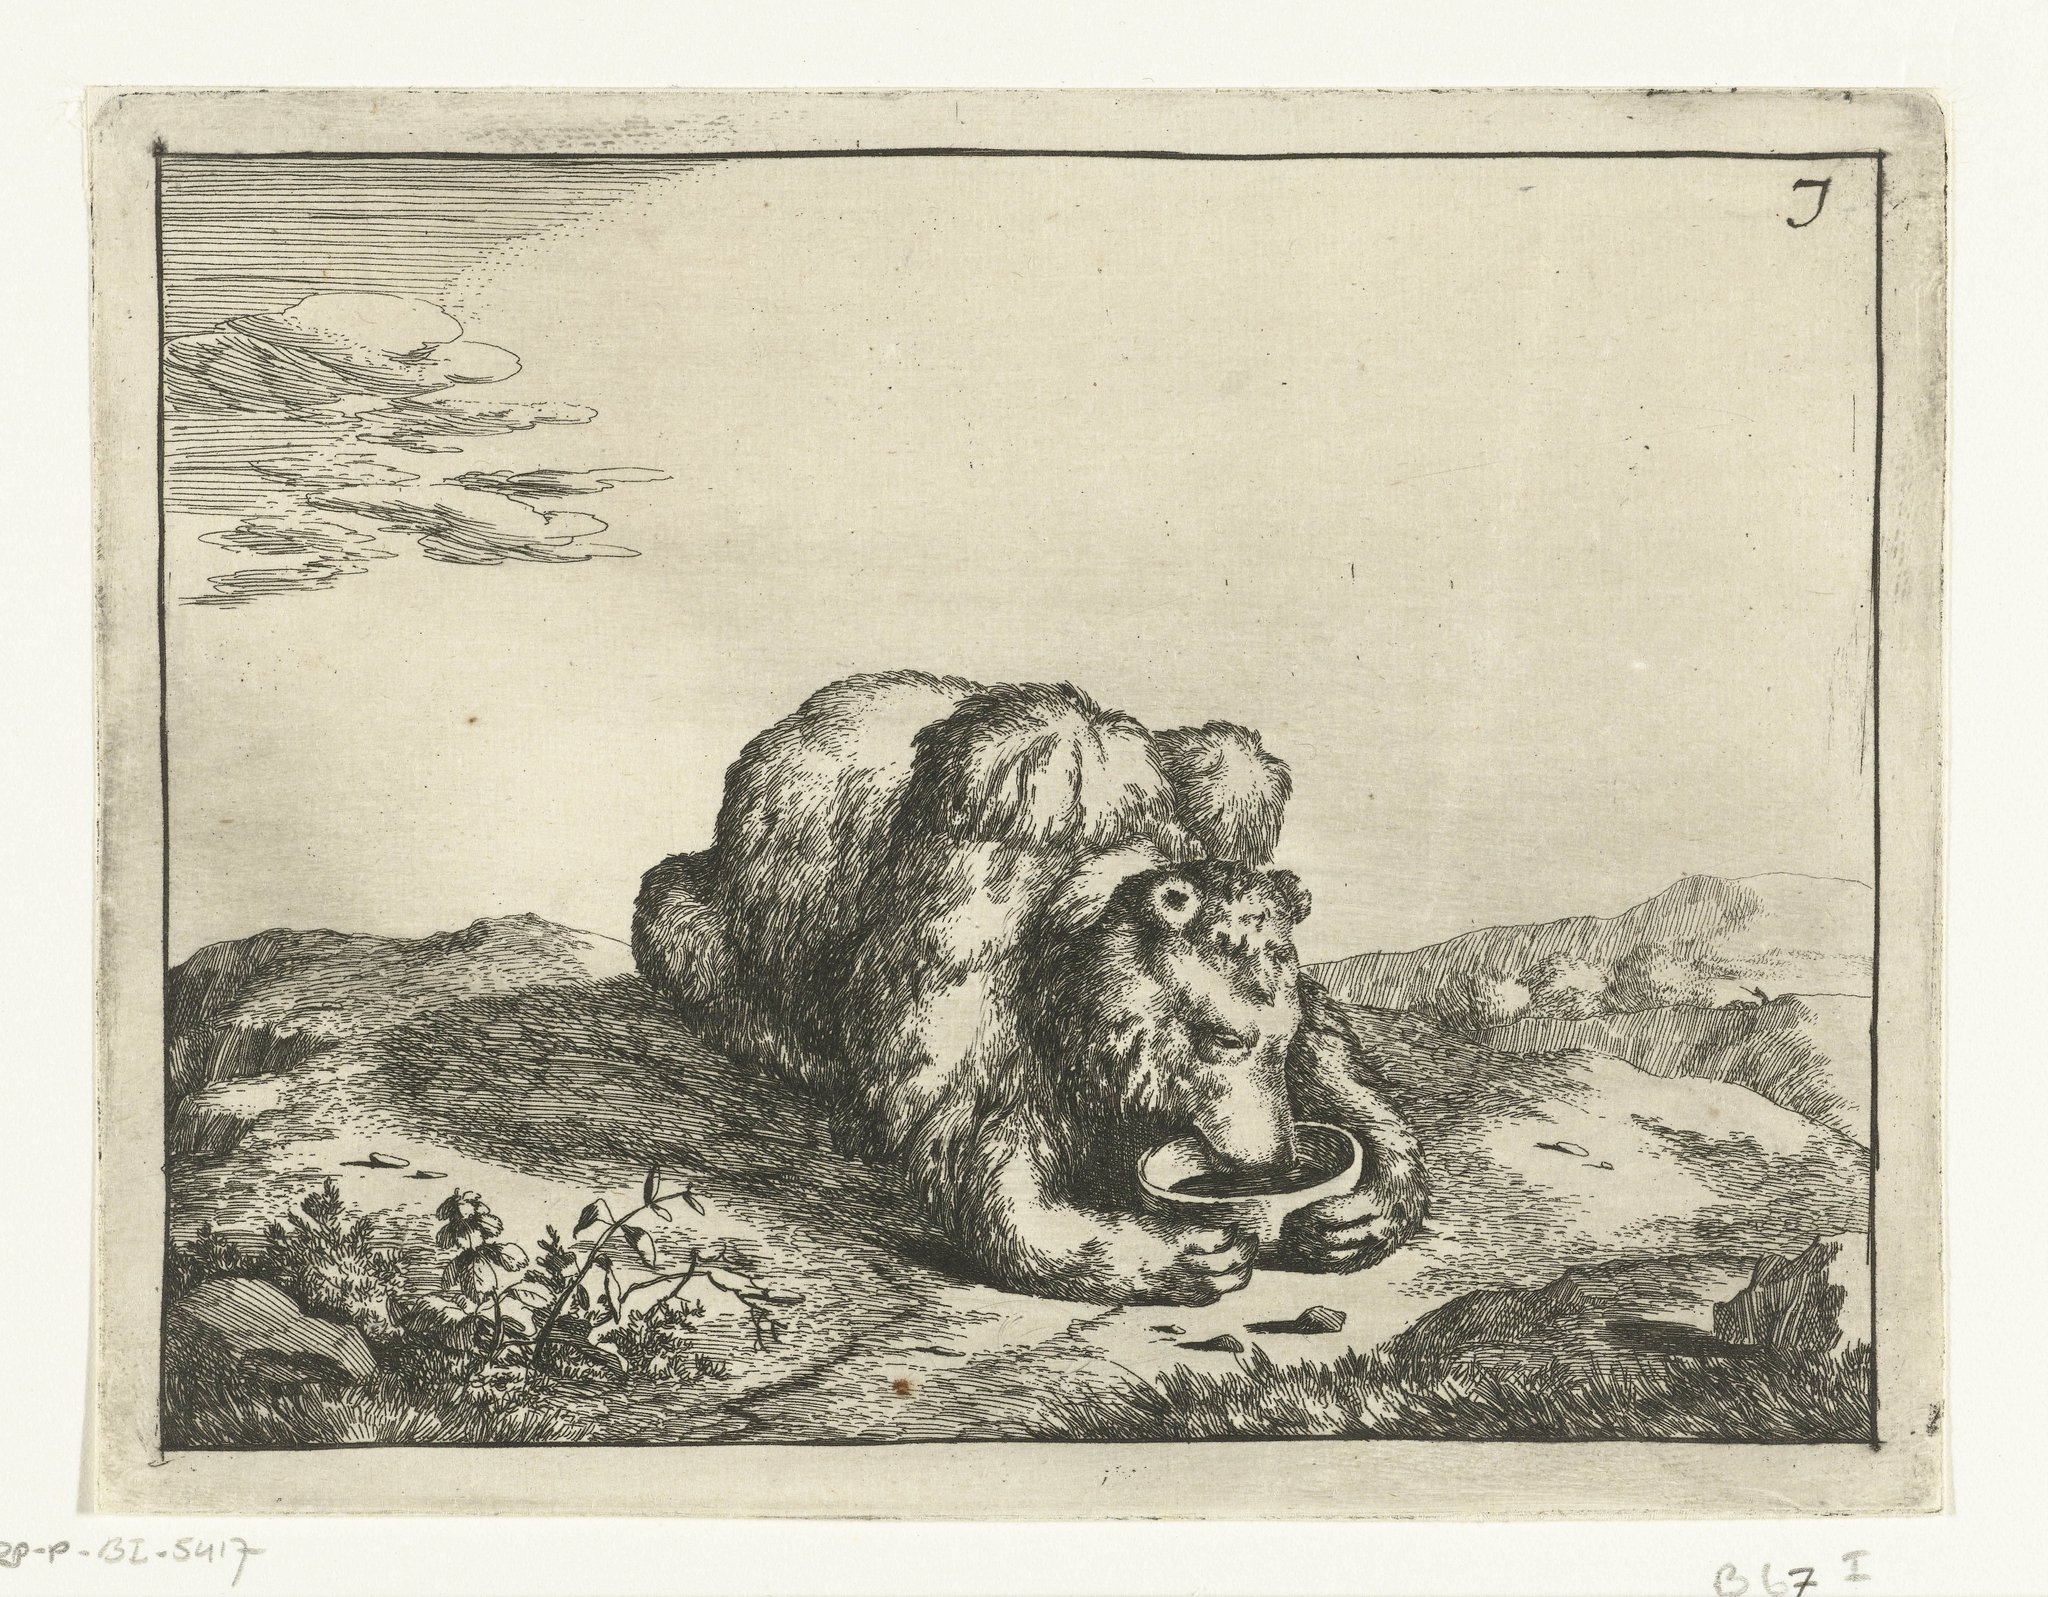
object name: print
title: Beren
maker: marcus de bye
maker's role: print maker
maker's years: 1639-1688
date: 1664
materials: paper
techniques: etching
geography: the hague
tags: beasts of prey, predatory animals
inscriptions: collector's mark: Lugt 240